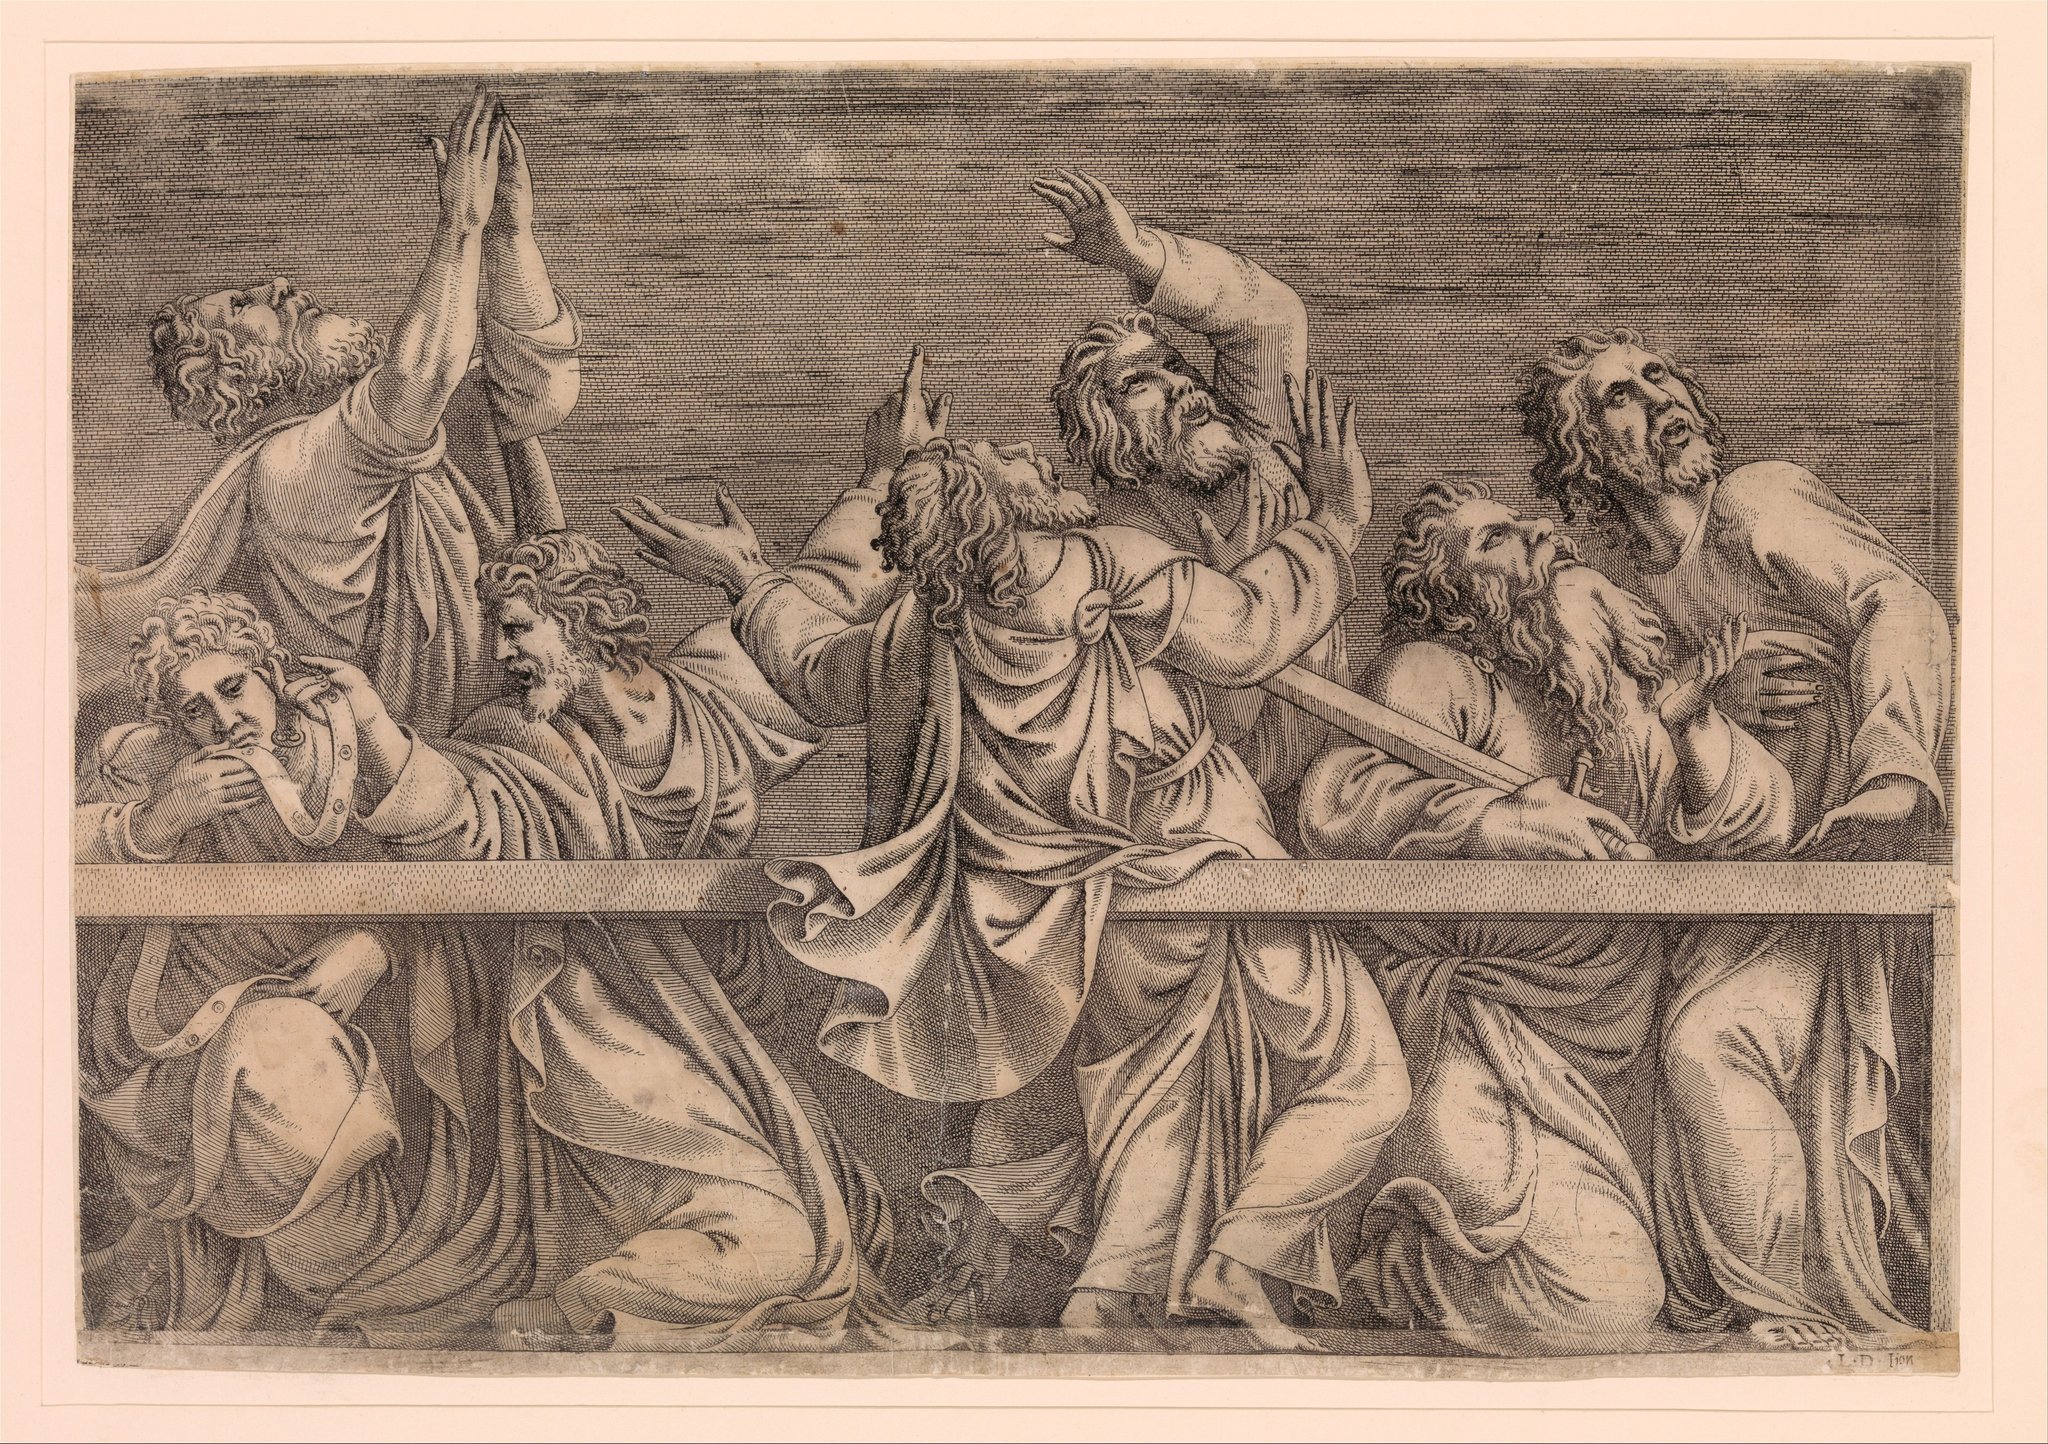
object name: print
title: The Apostles Looking at Christ and the Virgin in a Glory of Angels (bottom left plate)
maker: léon davent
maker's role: artist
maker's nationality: french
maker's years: 1540-1556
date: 1546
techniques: etching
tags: swords,apostles